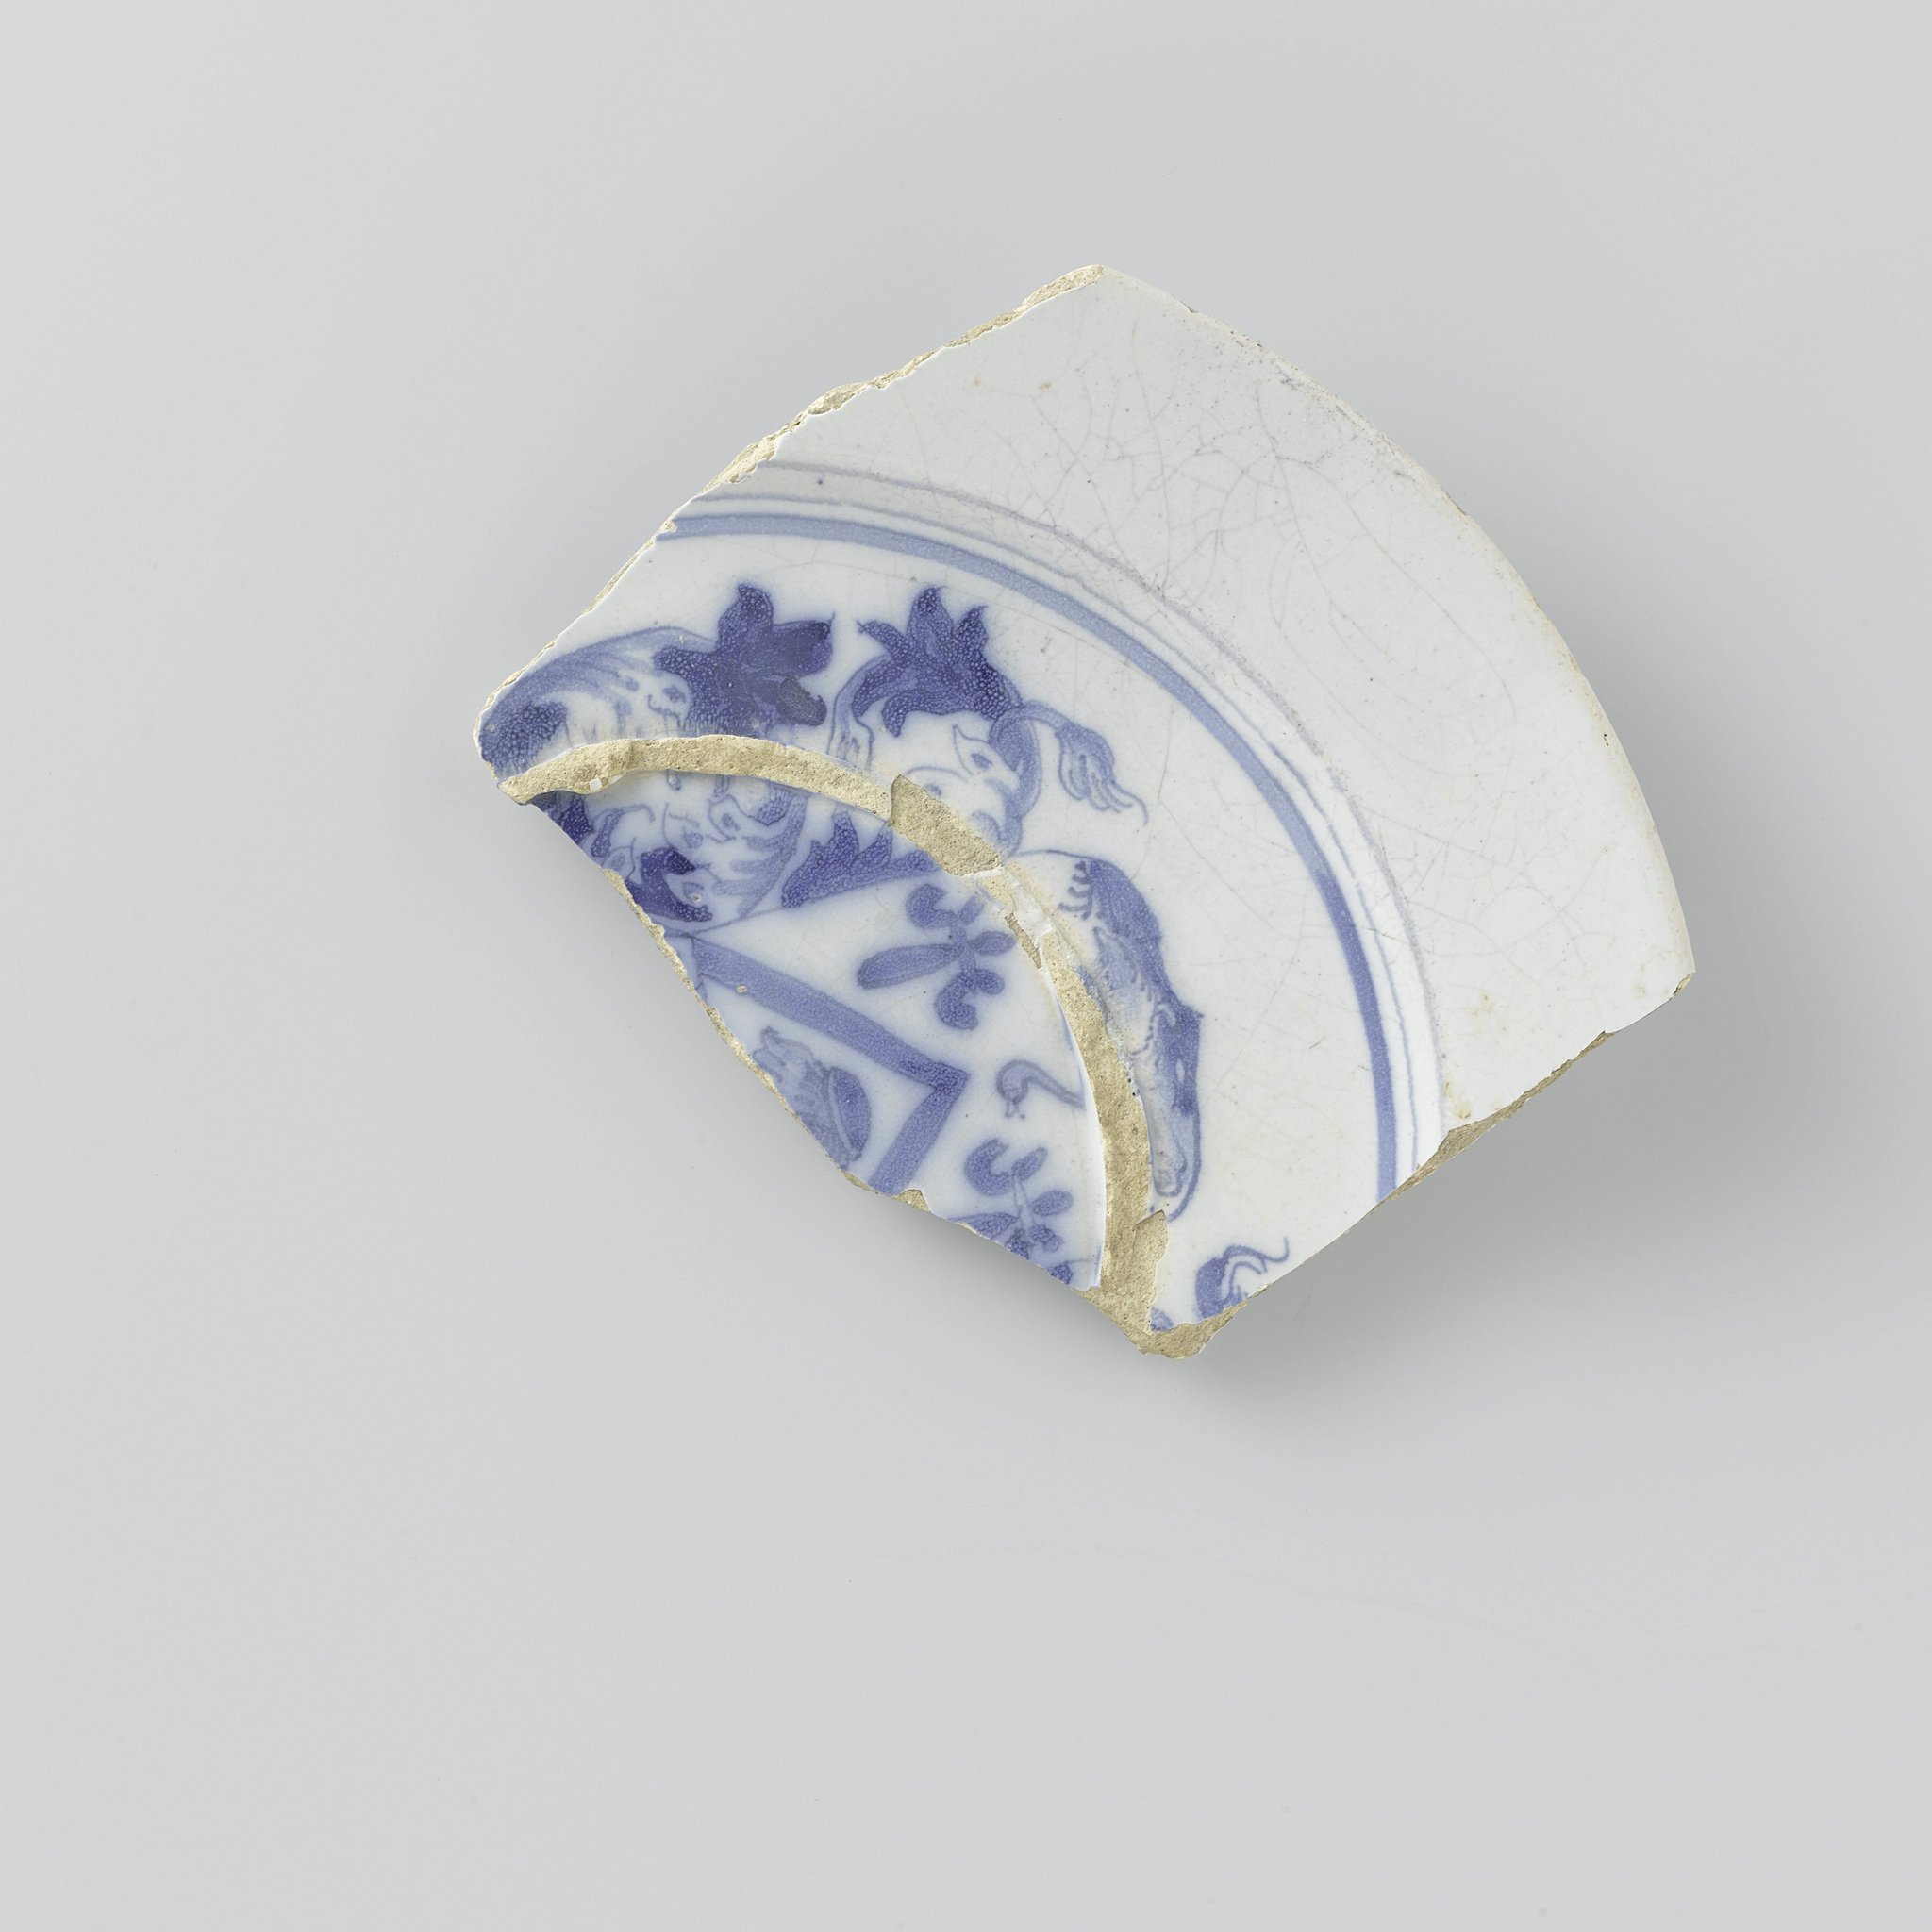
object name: plate dish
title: Fragment van een bord, beschilderd in blauw onder het glazuur met een wapenschild met dekkleden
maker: Anonymous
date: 1600-1650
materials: earthenware, glaze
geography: northern netherlands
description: Fragment van een bord van faience. Het plat is beschilderd in blauw onder het glazuur met een wapenschild met dekkleden, omgeven door concentrische cirkels. Door de voorstelling heen loopt een halfcirkelvormige beschadiging